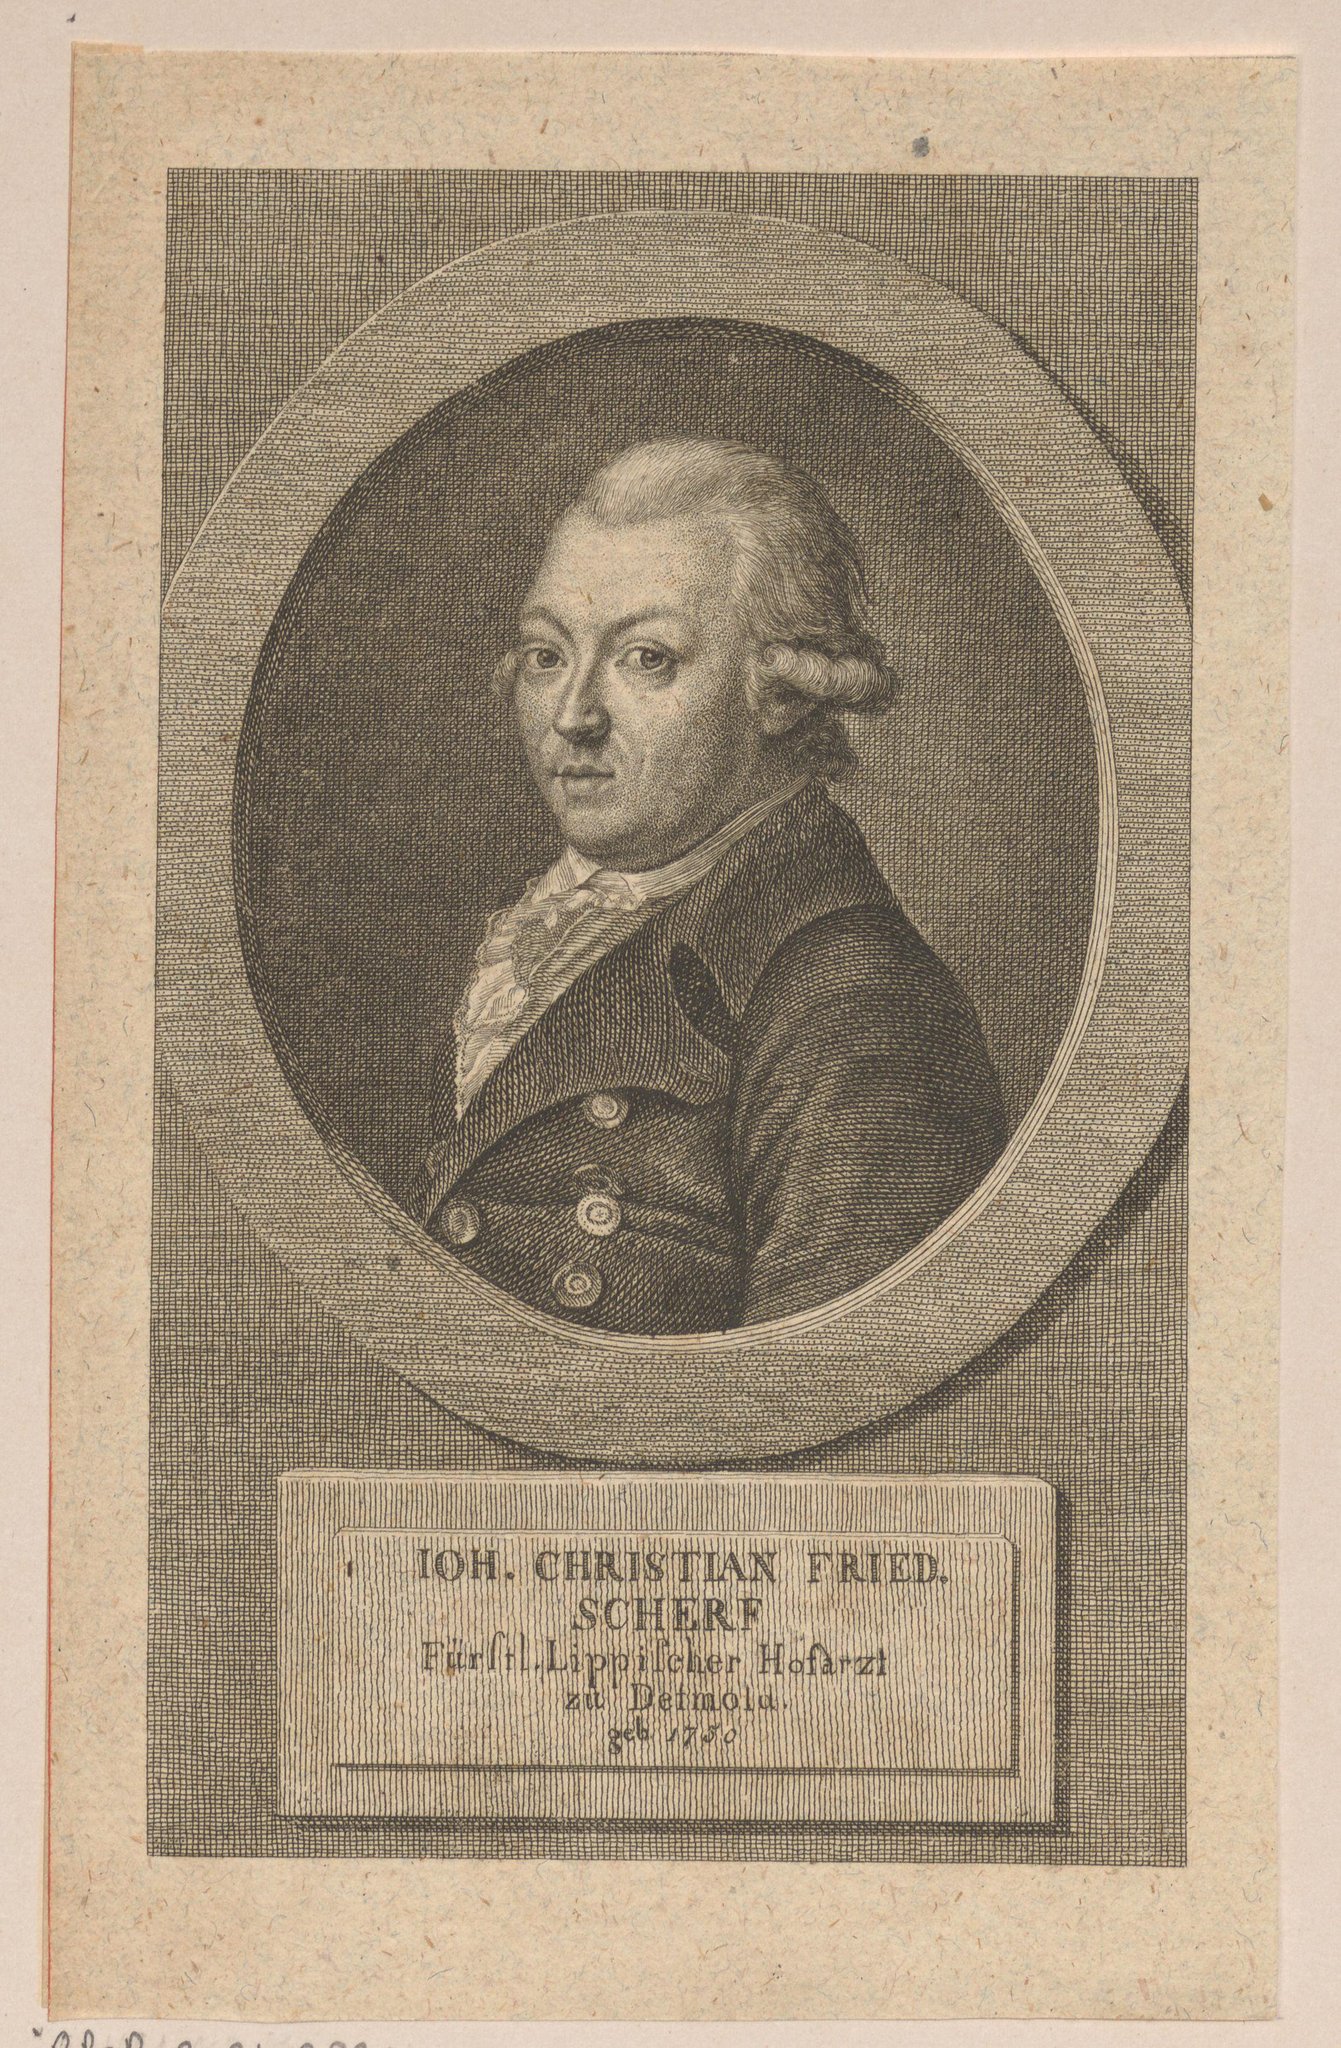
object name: print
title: Portret van Johann Christian Friedrich Scherf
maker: eberhard siegfried henne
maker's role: print maker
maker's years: 1759-1828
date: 1791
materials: paper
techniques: engraving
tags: pharmacist, druggist, apothecary; pharmacy, drugstore, dispensing chemist, historical persons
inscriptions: collector's mark: Lugt 2228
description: Prent mogelijk uit: Allgemeine deutsche Bibliothek. Berlijn en Stettin: Friedrich Nicolai, 1791, dl. 100.